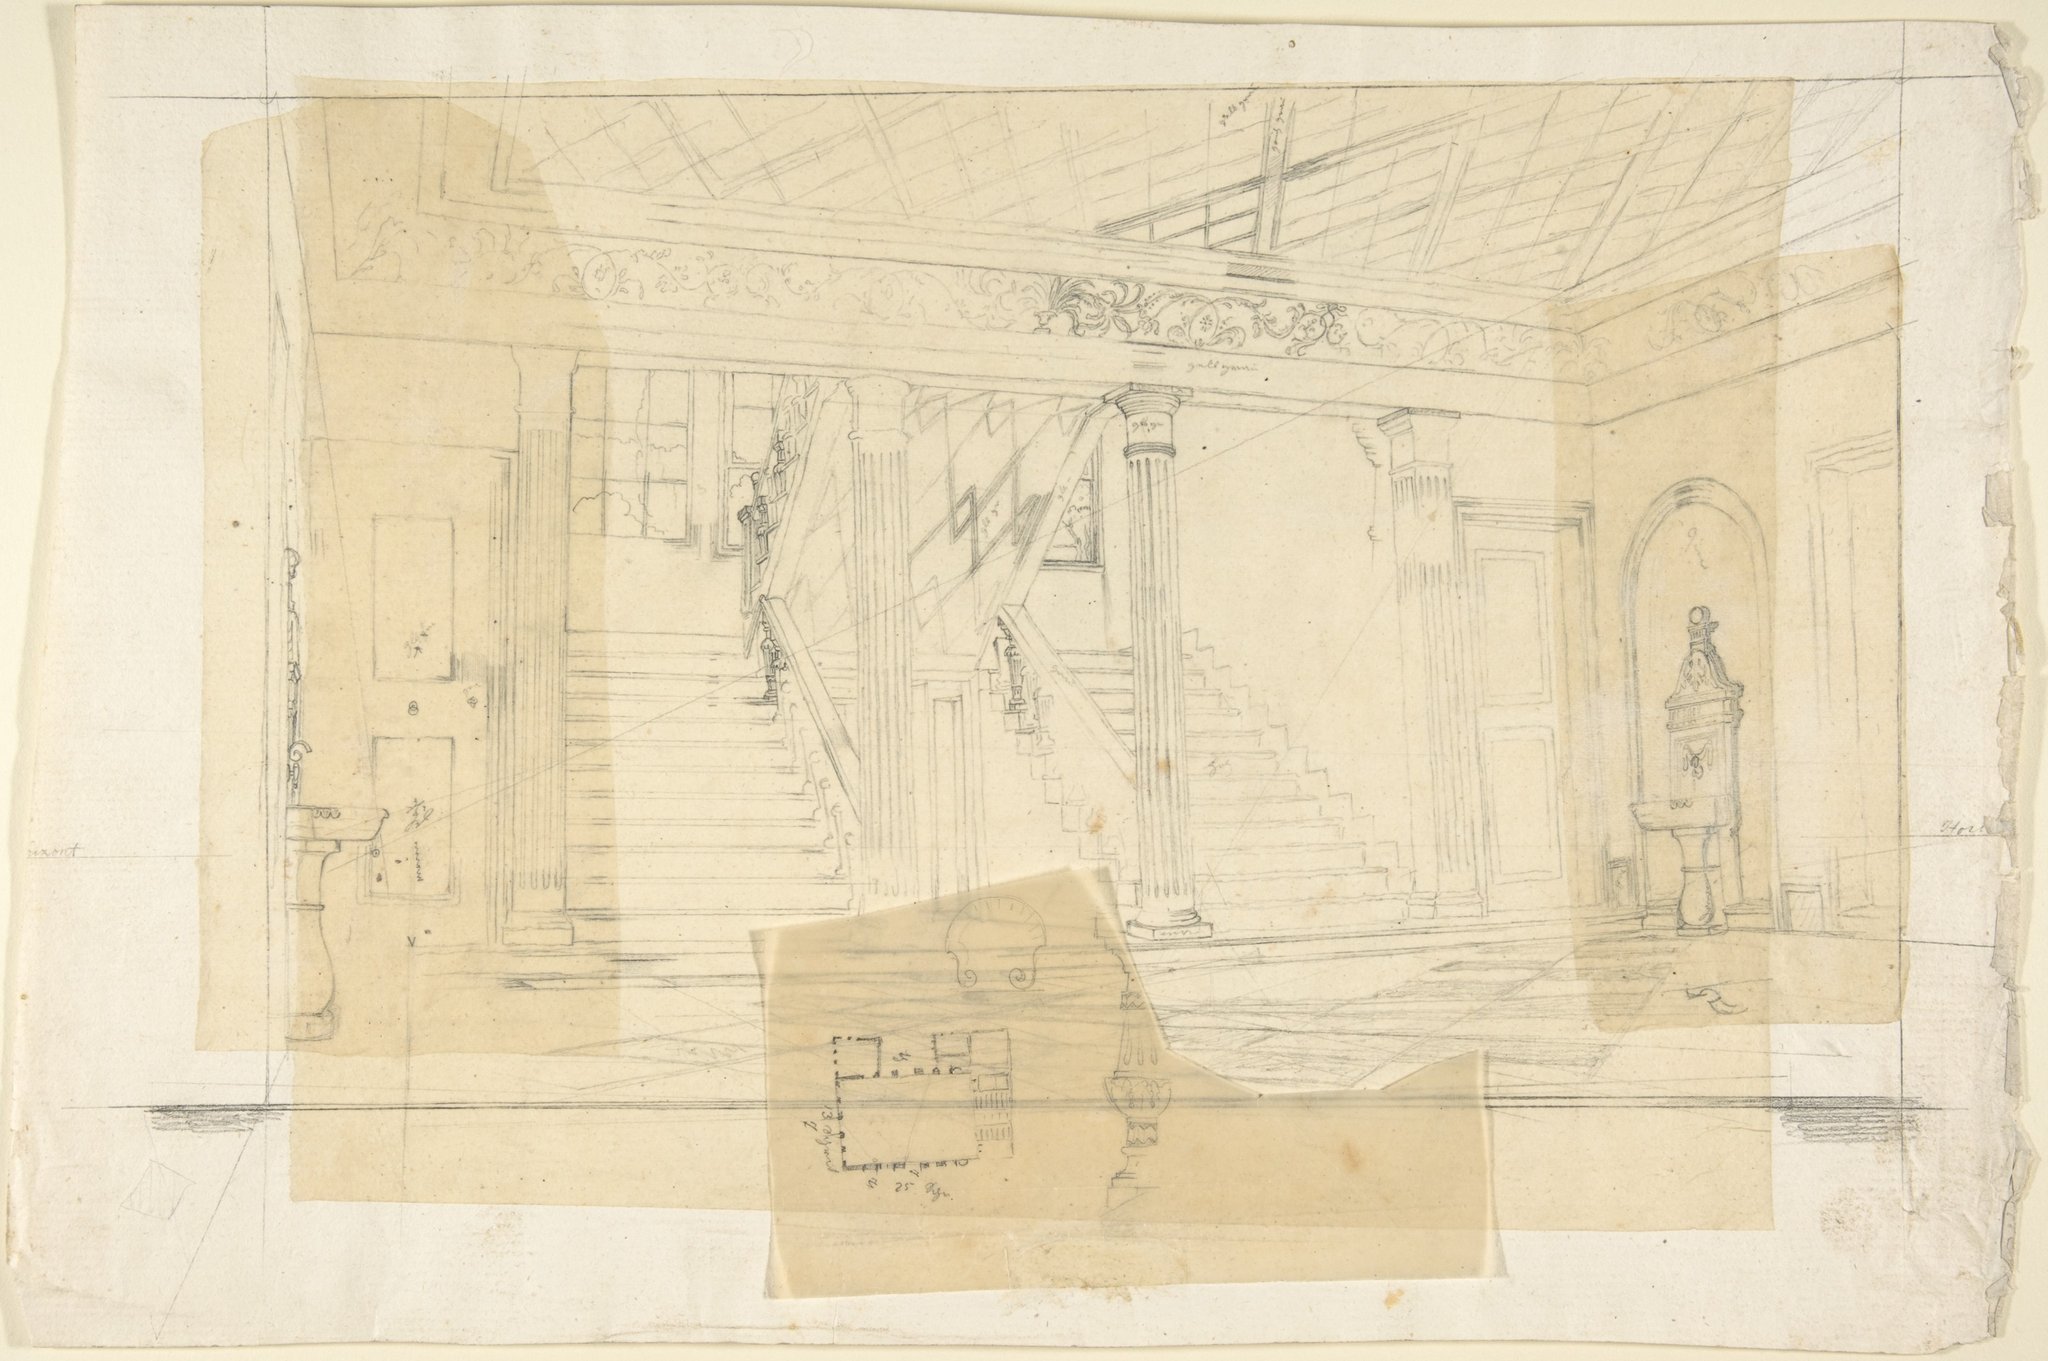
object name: drawing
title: Interior of the Alhambra(?)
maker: franz von hauslab the younger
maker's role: artist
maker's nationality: austrian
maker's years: 1798-1883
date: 1801-1900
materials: paper, pencil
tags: columns,stairs,interiors